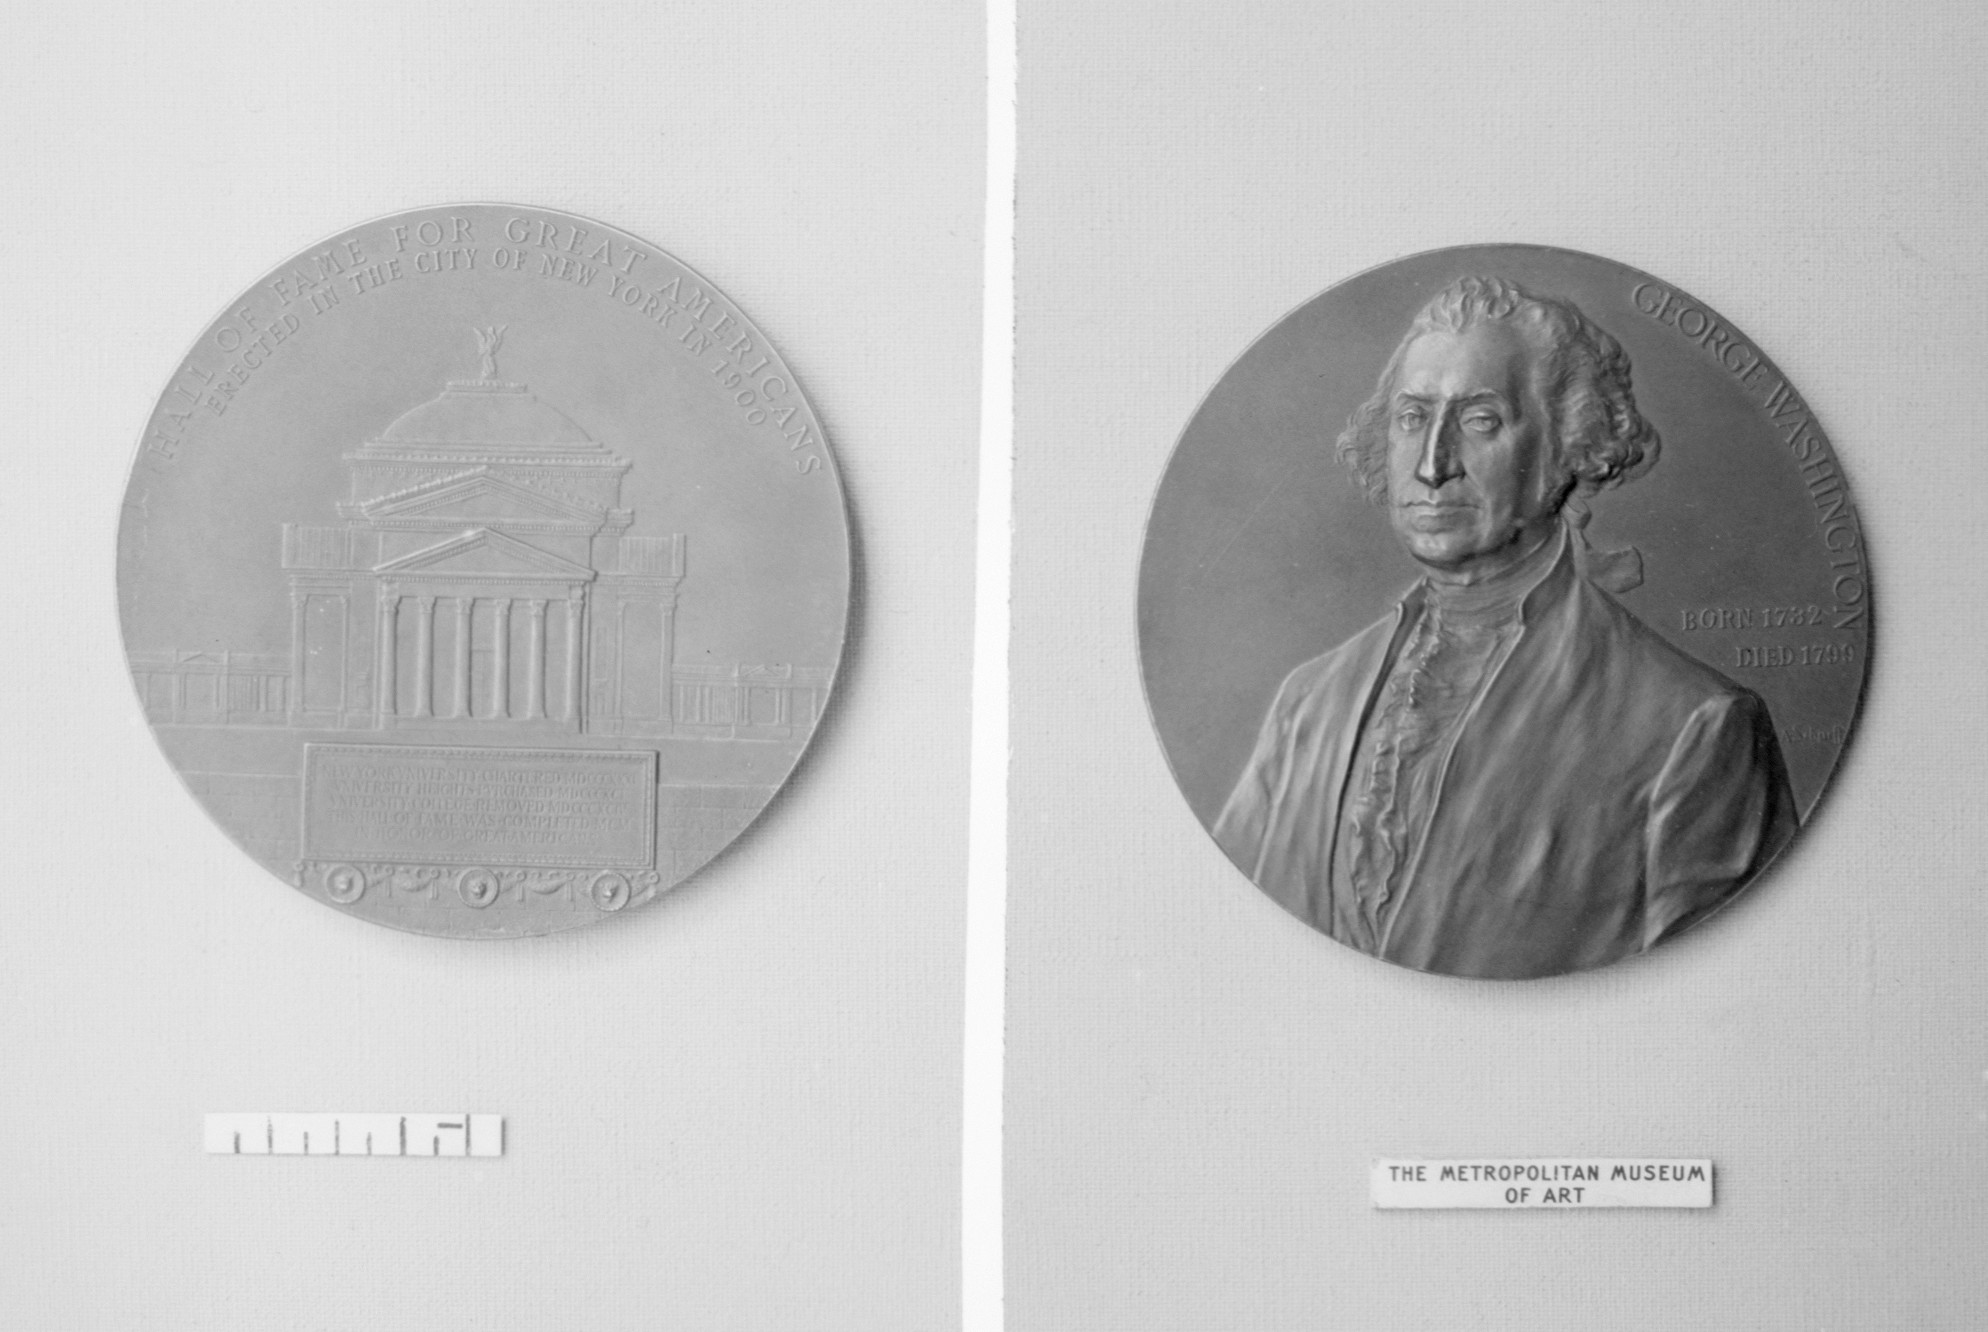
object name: medal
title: Inauguration of the American Hall of Fame, 1900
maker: anton scharff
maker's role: artist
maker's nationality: austrian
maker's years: 1845-1903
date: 1900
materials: bronze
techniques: struck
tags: buildings,george washington,portraits